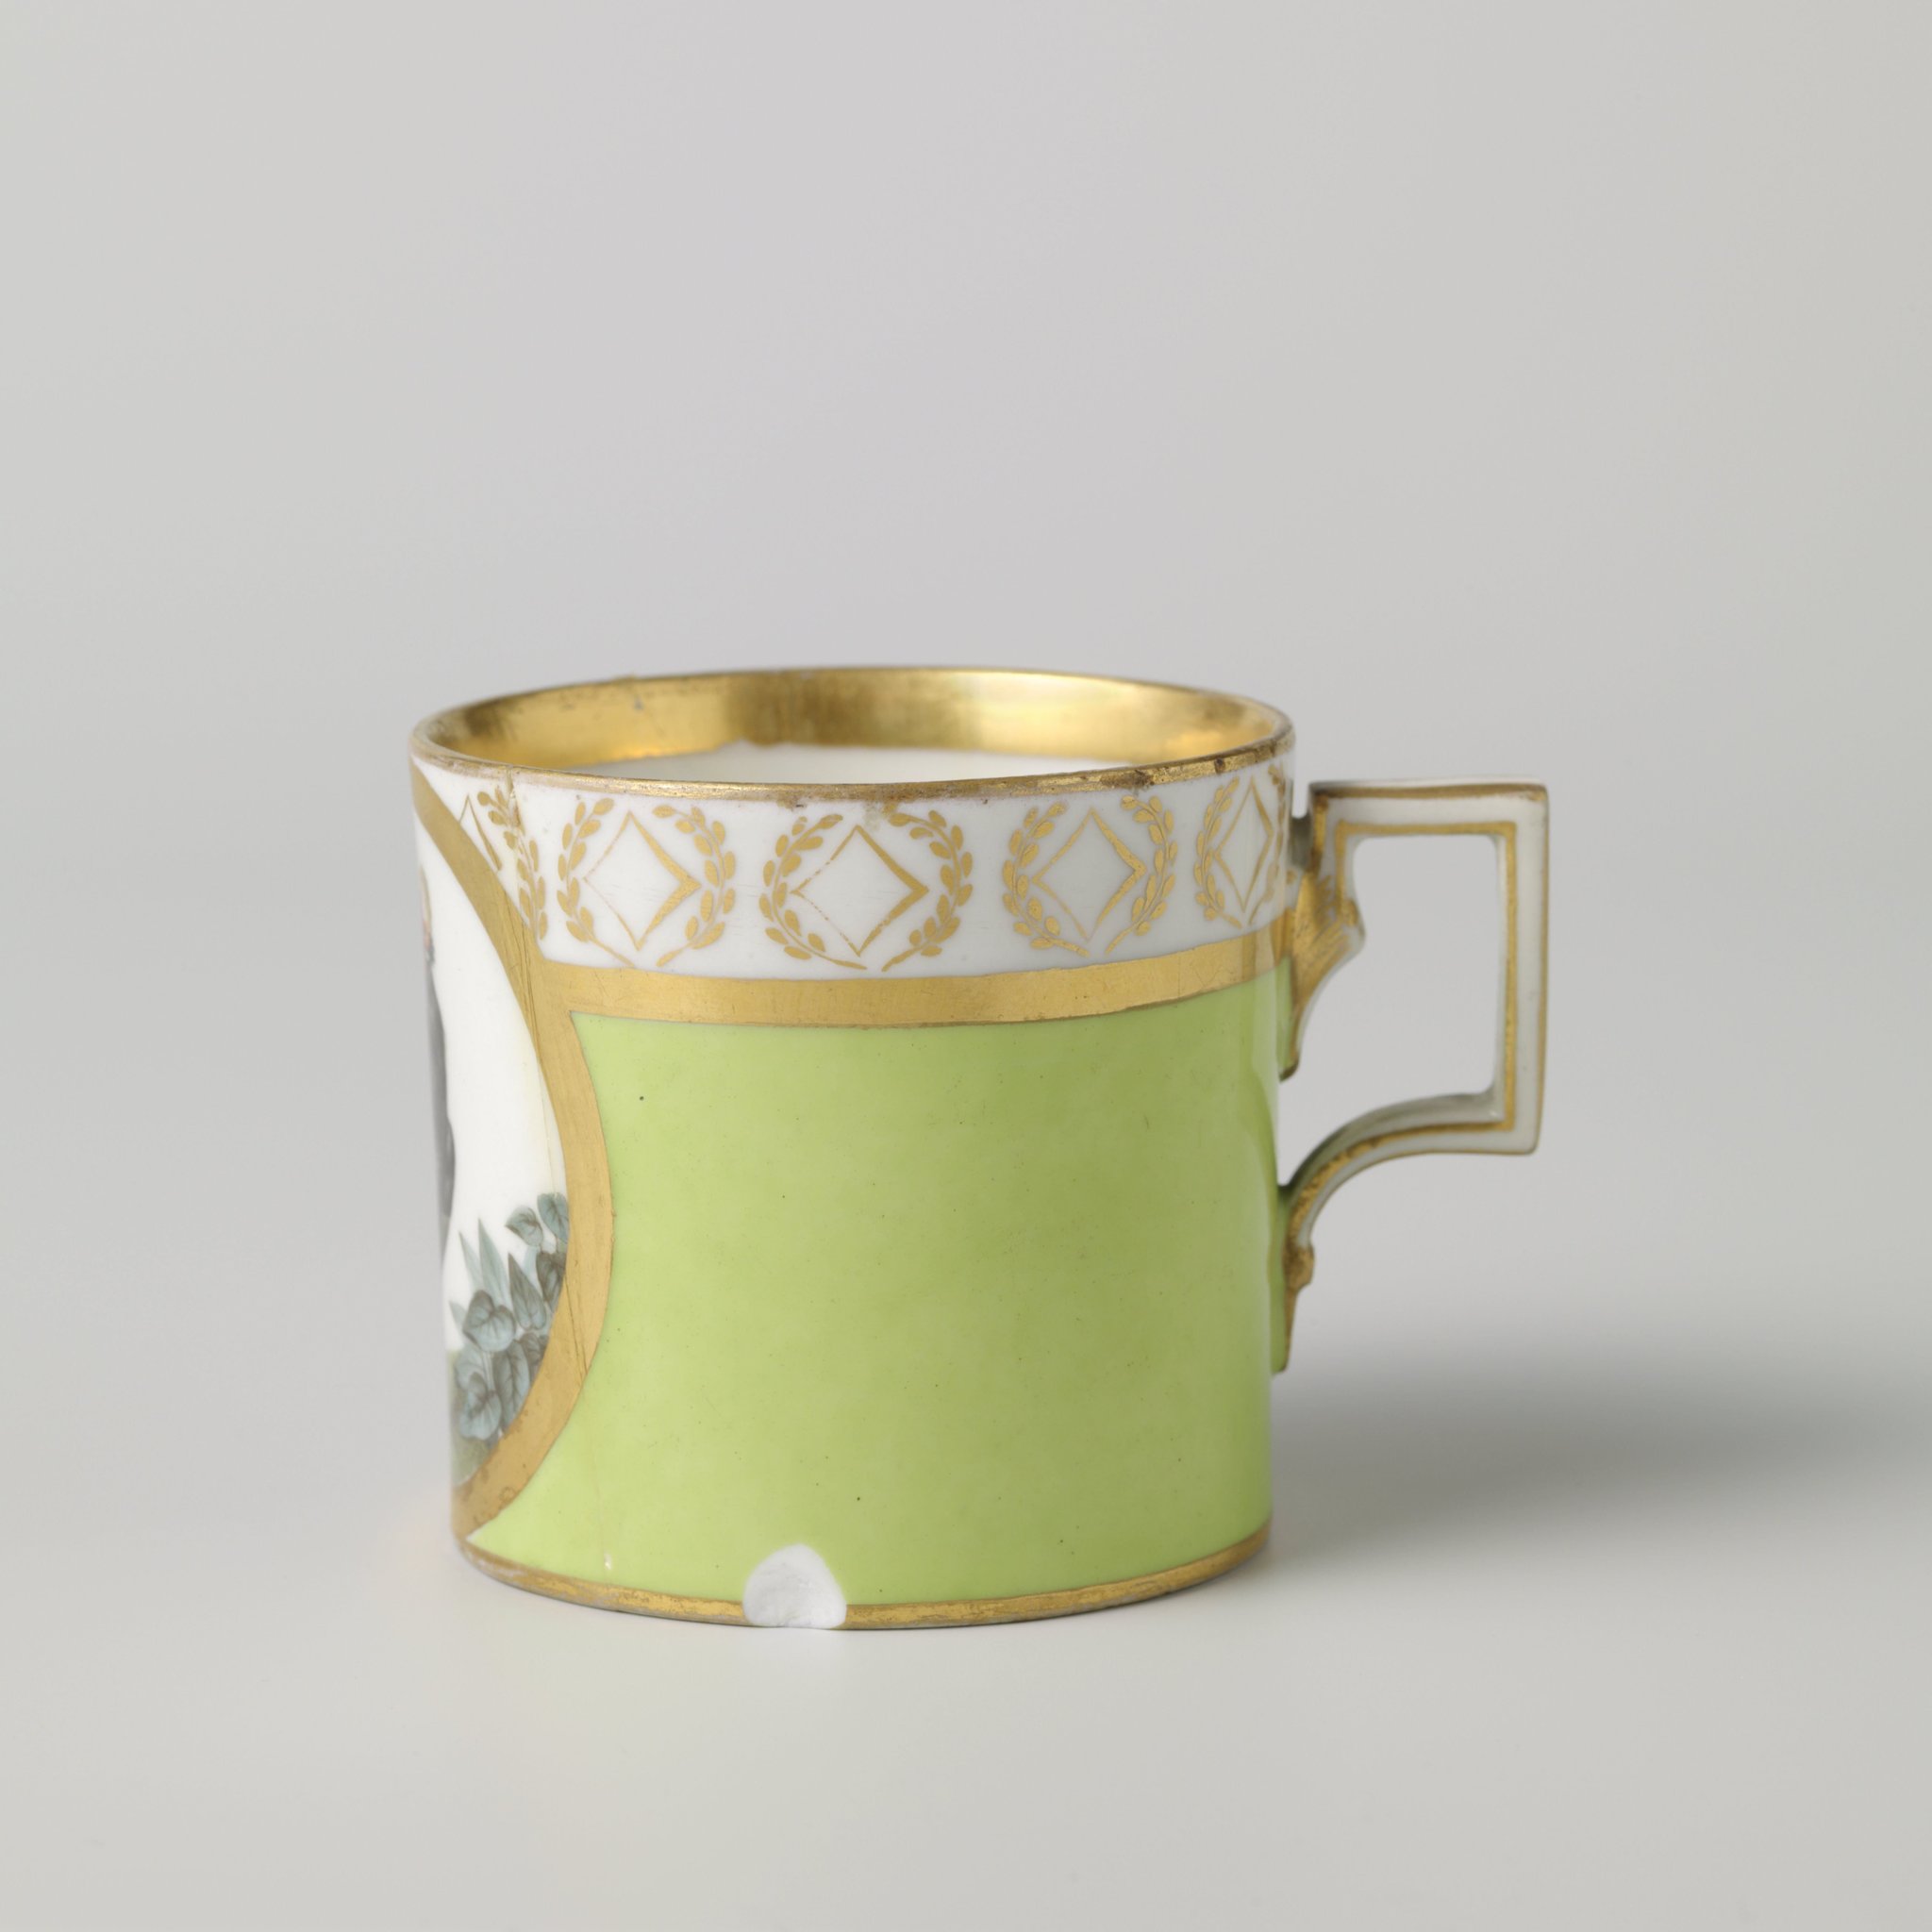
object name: cup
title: Cup with a rooster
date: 1809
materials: glaze, gold, paint, porcelain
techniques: firing, forming, gilding, turning, vitrification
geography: vienna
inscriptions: mark: ‘schild/ X/ 47, 809’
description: Kop van porselein met een cilindrisch lichaam en hoekig oor, beschilderd op het glazuur in rood, groen, zwart en goud. De buitenzijde van de kop is bedekt met groen, met daarin uitgespaard tweemaal een gouden medaillon met een haan in een landschap. Op de buitenwand een band met ruiten in bladerkransen. Gemerkt op de onderzijde met het schild, X, het nummer 47 en jaarnummer 809. Barst in de wand, doorlopend naar de bodem.